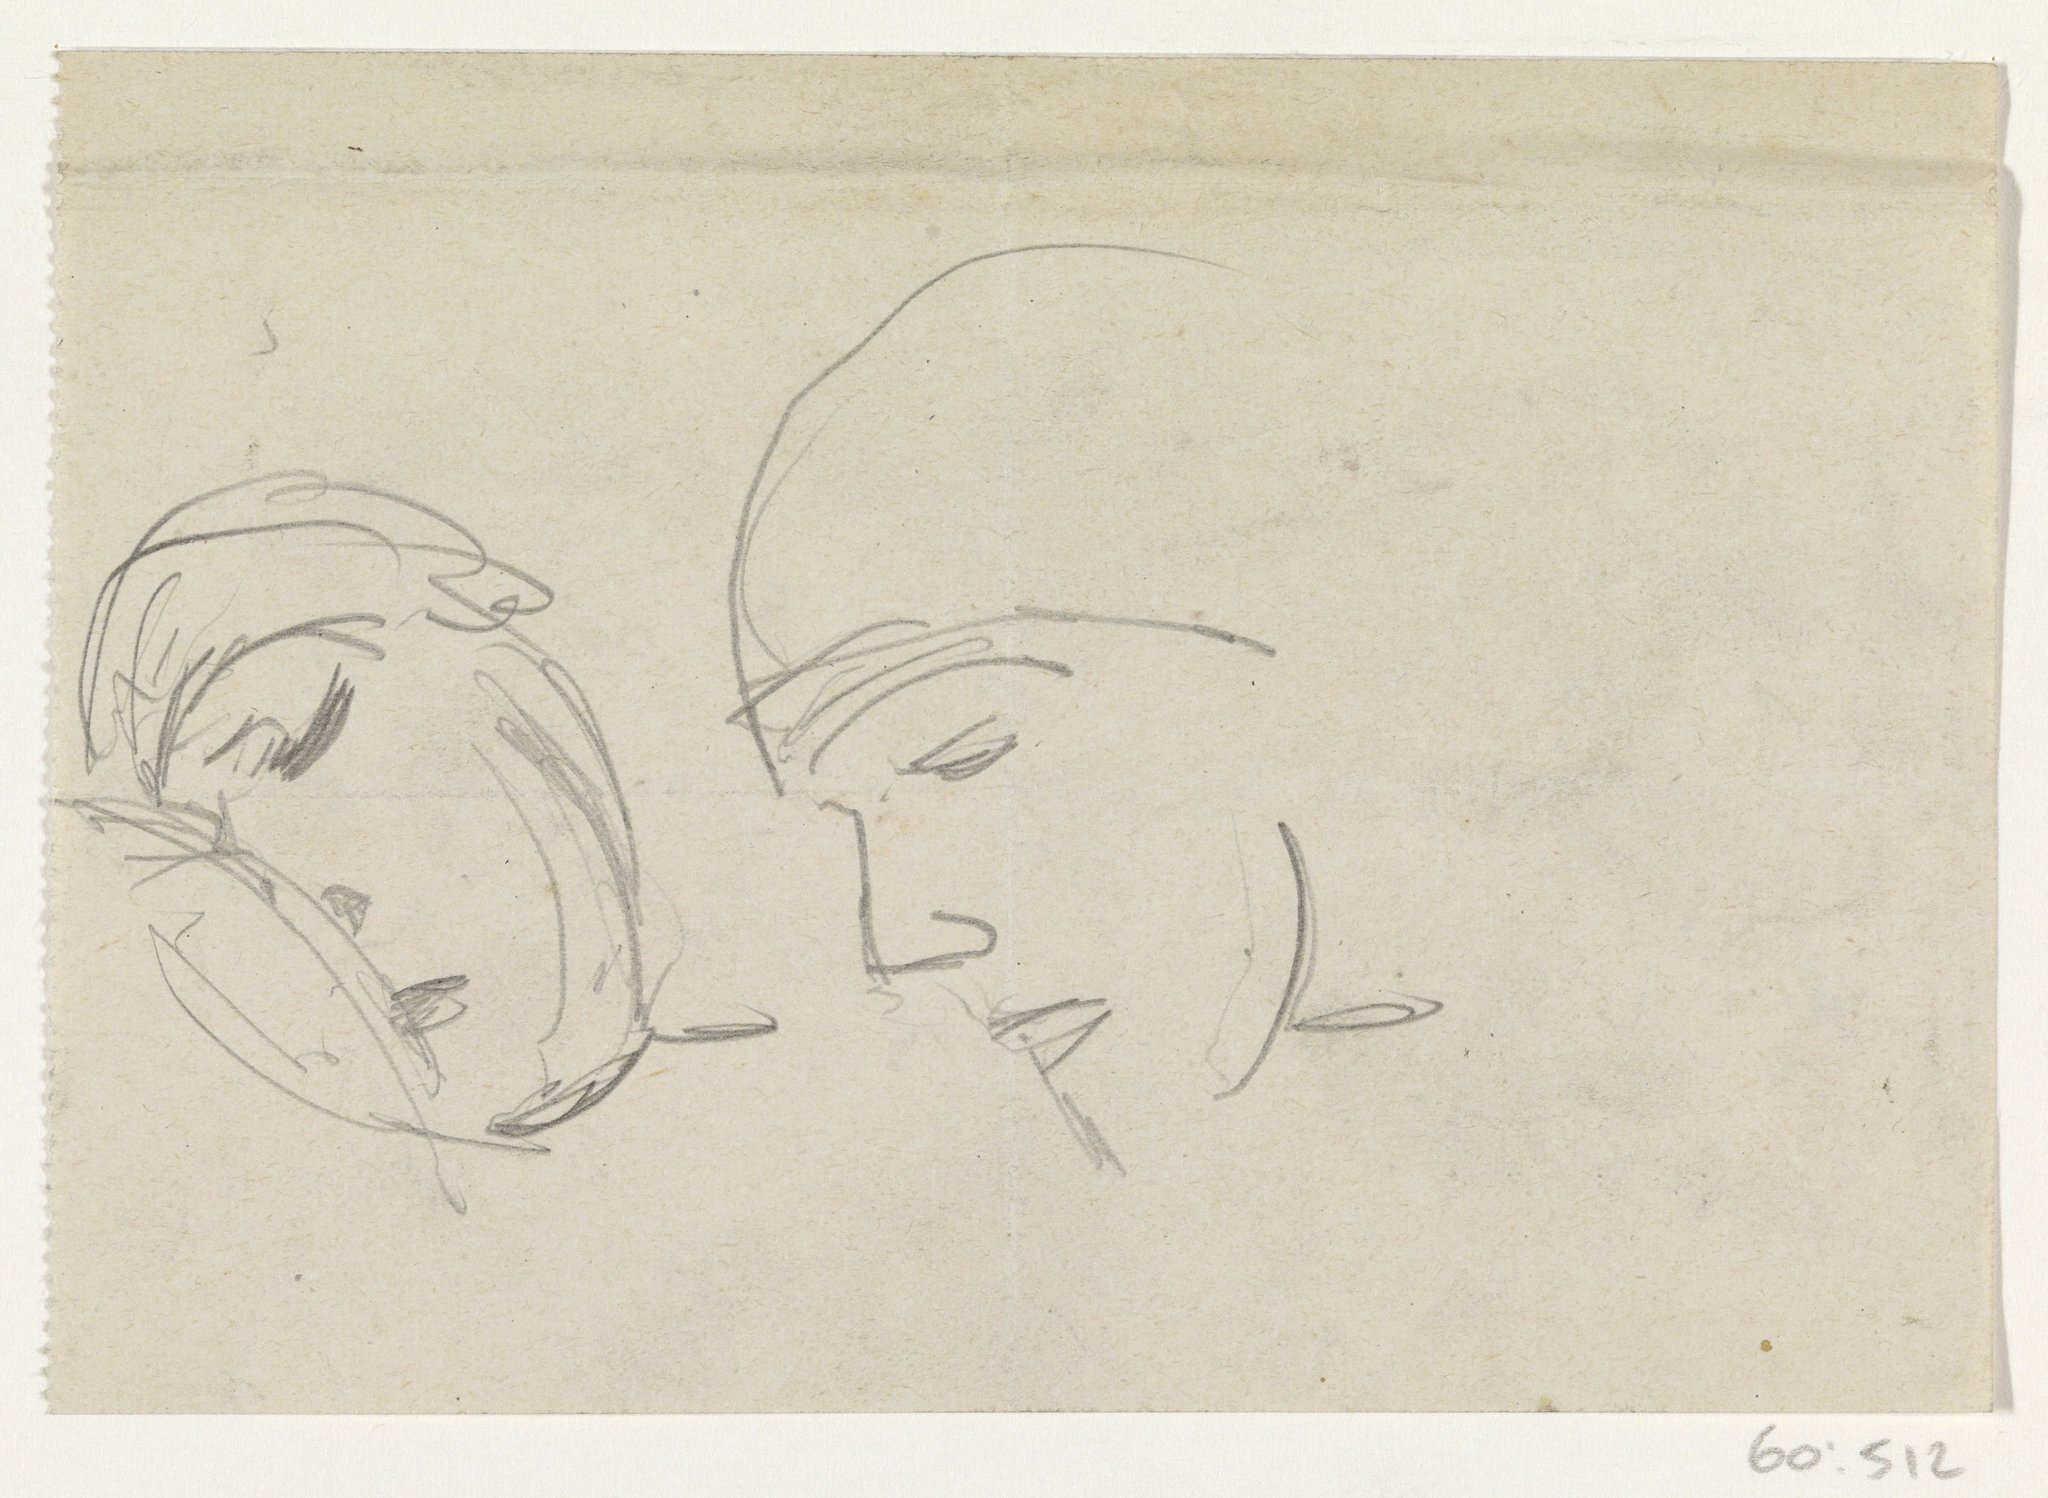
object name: drawing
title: Twee vrouwenhoofden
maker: leo gestel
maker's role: draughtsman, print maker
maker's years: 1881-1941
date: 1891-1941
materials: paper, pencil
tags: head (human)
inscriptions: collector's mark: Lugt 2228